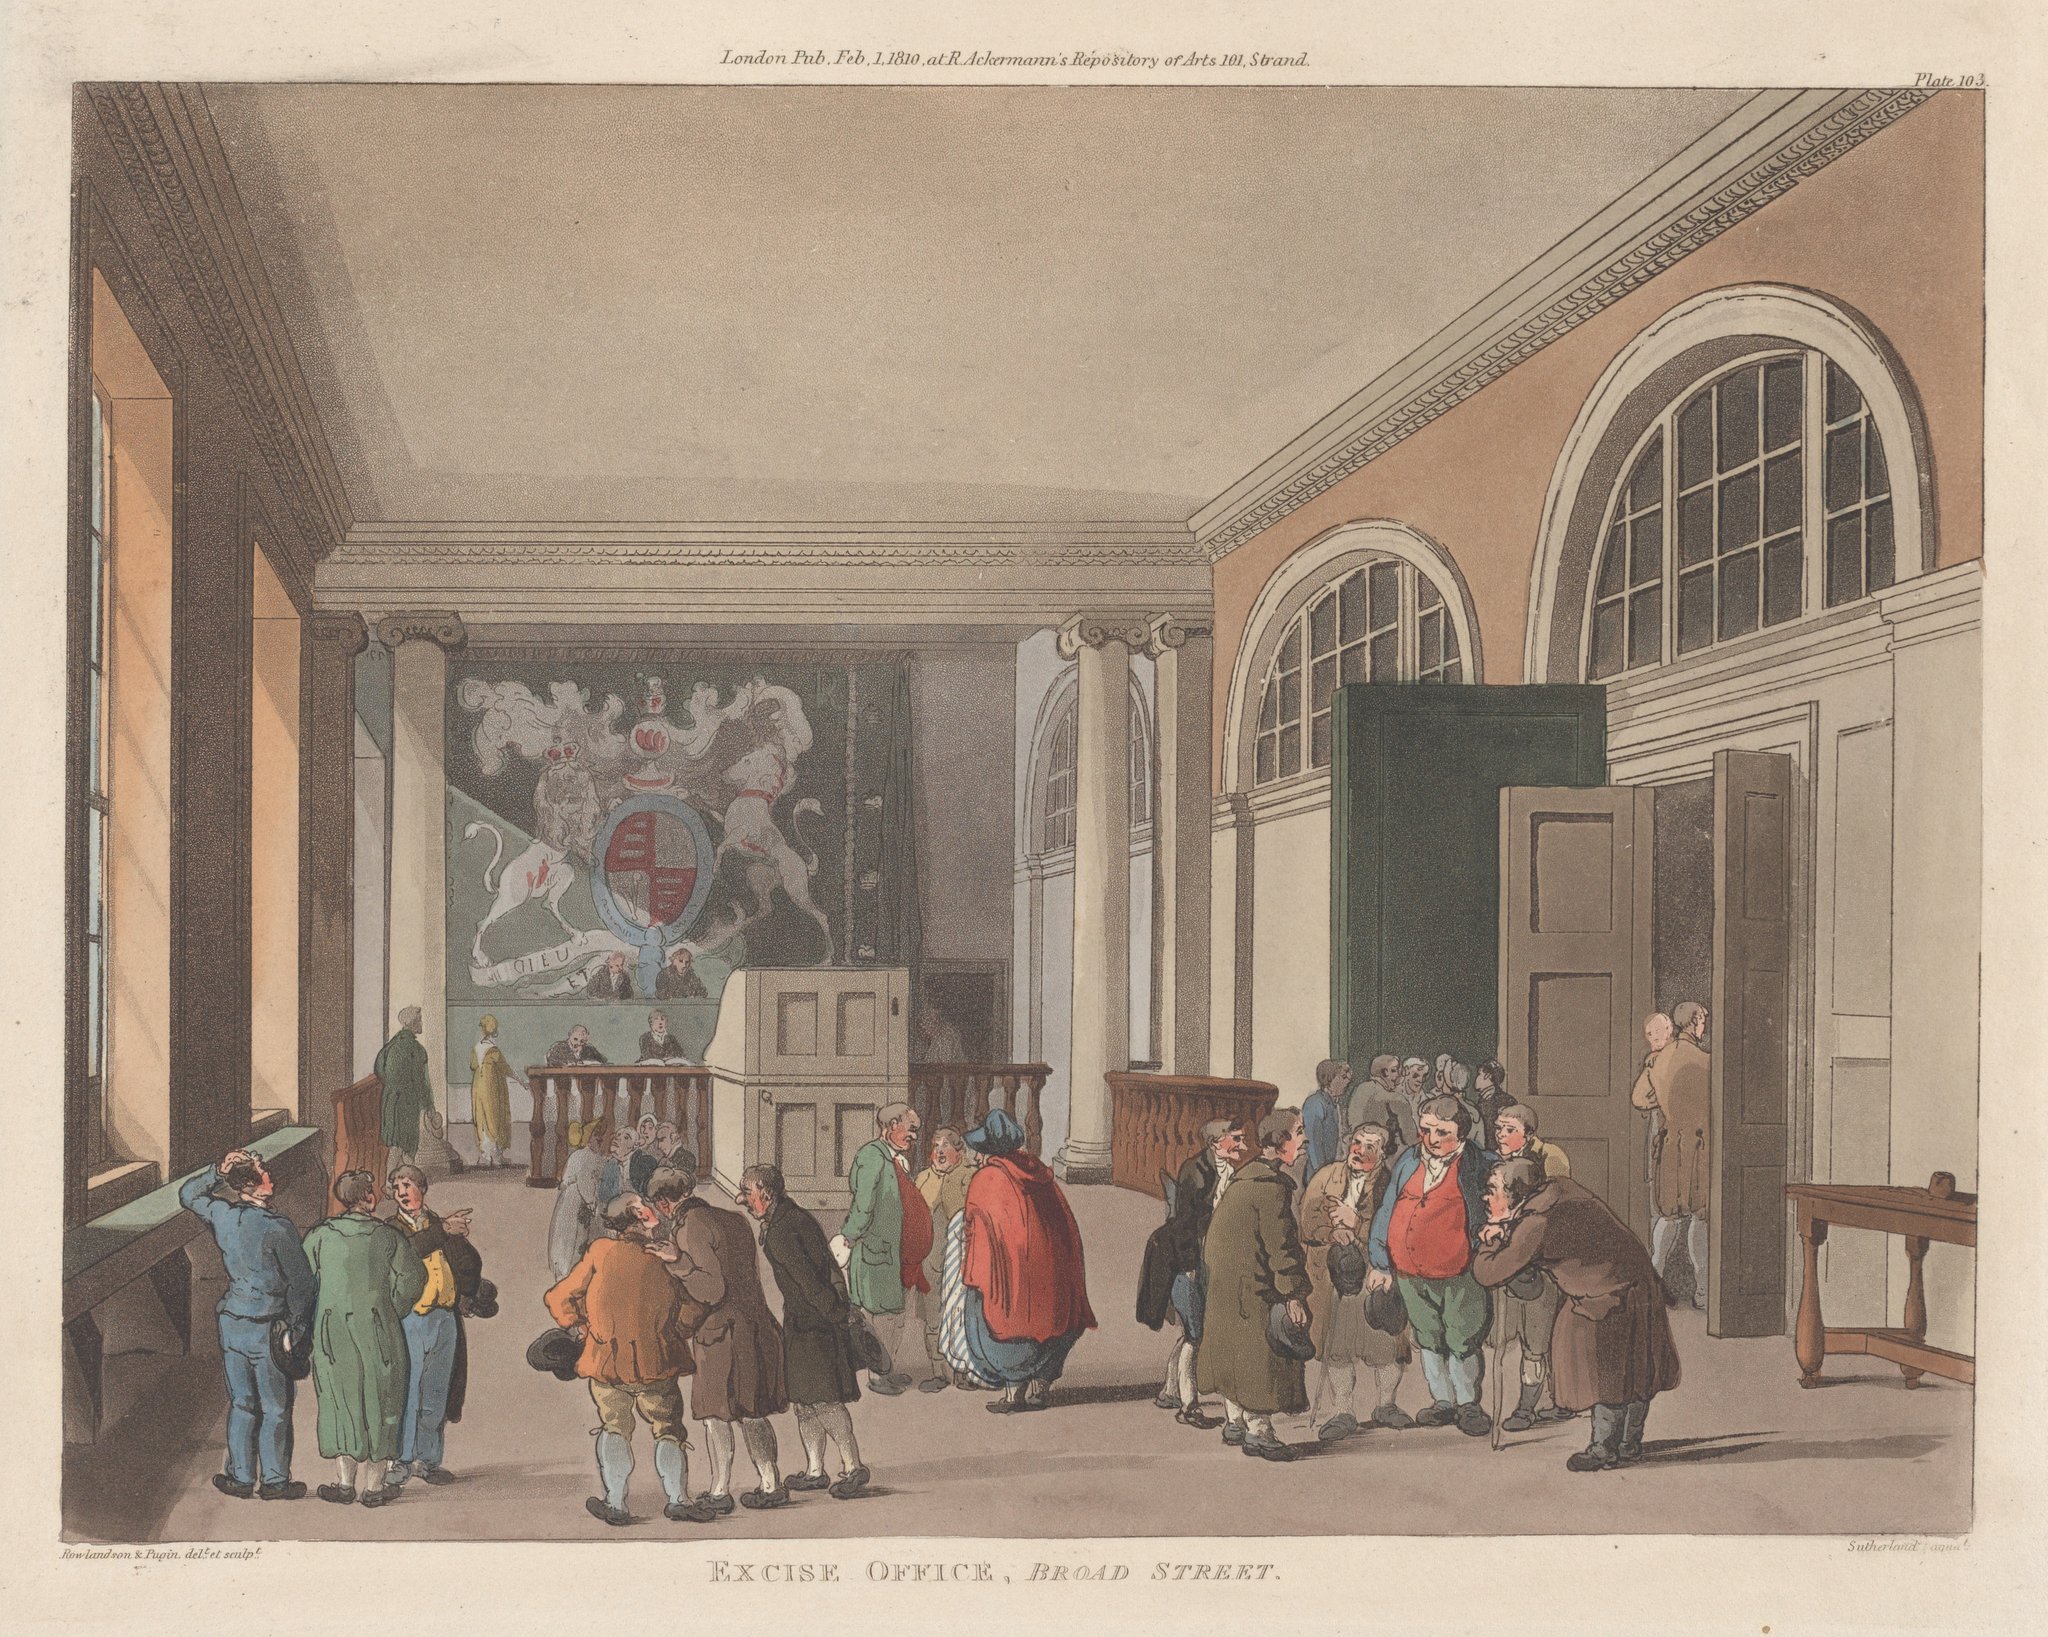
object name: print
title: Excise Office, Broad Street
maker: thomas rowlandson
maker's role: artist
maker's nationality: british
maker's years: 1757-1827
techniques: aquatint, etching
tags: interiors,men